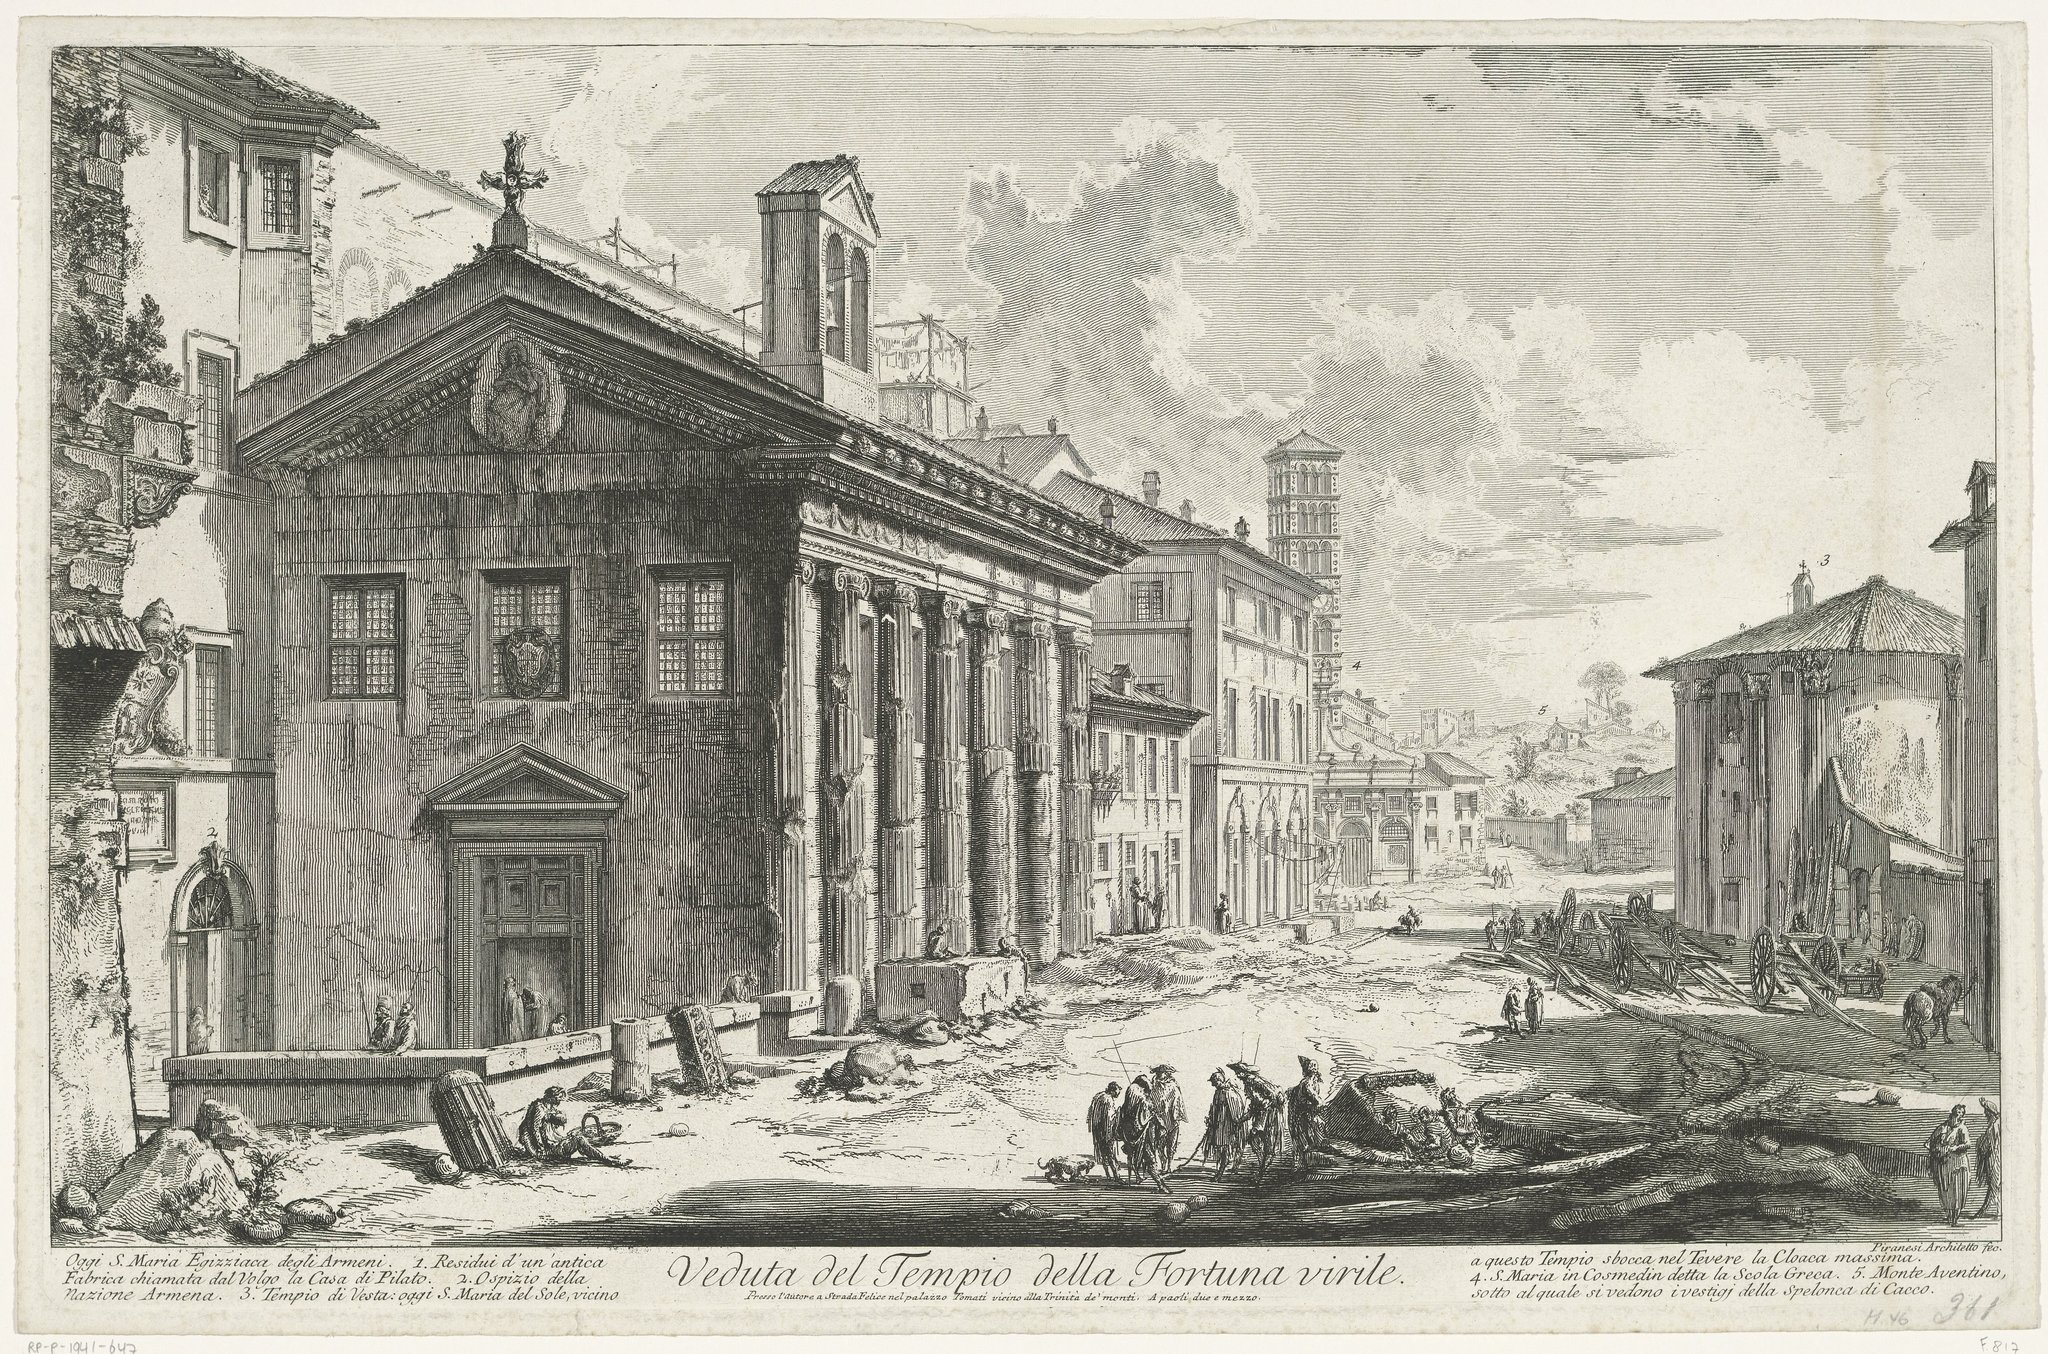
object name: print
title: Gezichten op Rome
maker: giovanni battista piranesi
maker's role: designer, draughtsman, print maker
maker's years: 1720-1778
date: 1748-1778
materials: paper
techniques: etching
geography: rome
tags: ruin of a building ~ architecture, fortuna as roman personification, temple, shrine ~ roman religion, rome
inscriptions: collector's mark: Lugt 2228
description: Deze prent maakt deel uit van de serie 'Vedute di Roma'. Piranesi werkte aan deze 135 platen tellende serie tussen 1748 en zijn dood in 1778. Francesco Piranesi voegde later nog twee prenten toe aan de reeks van zijn vader.